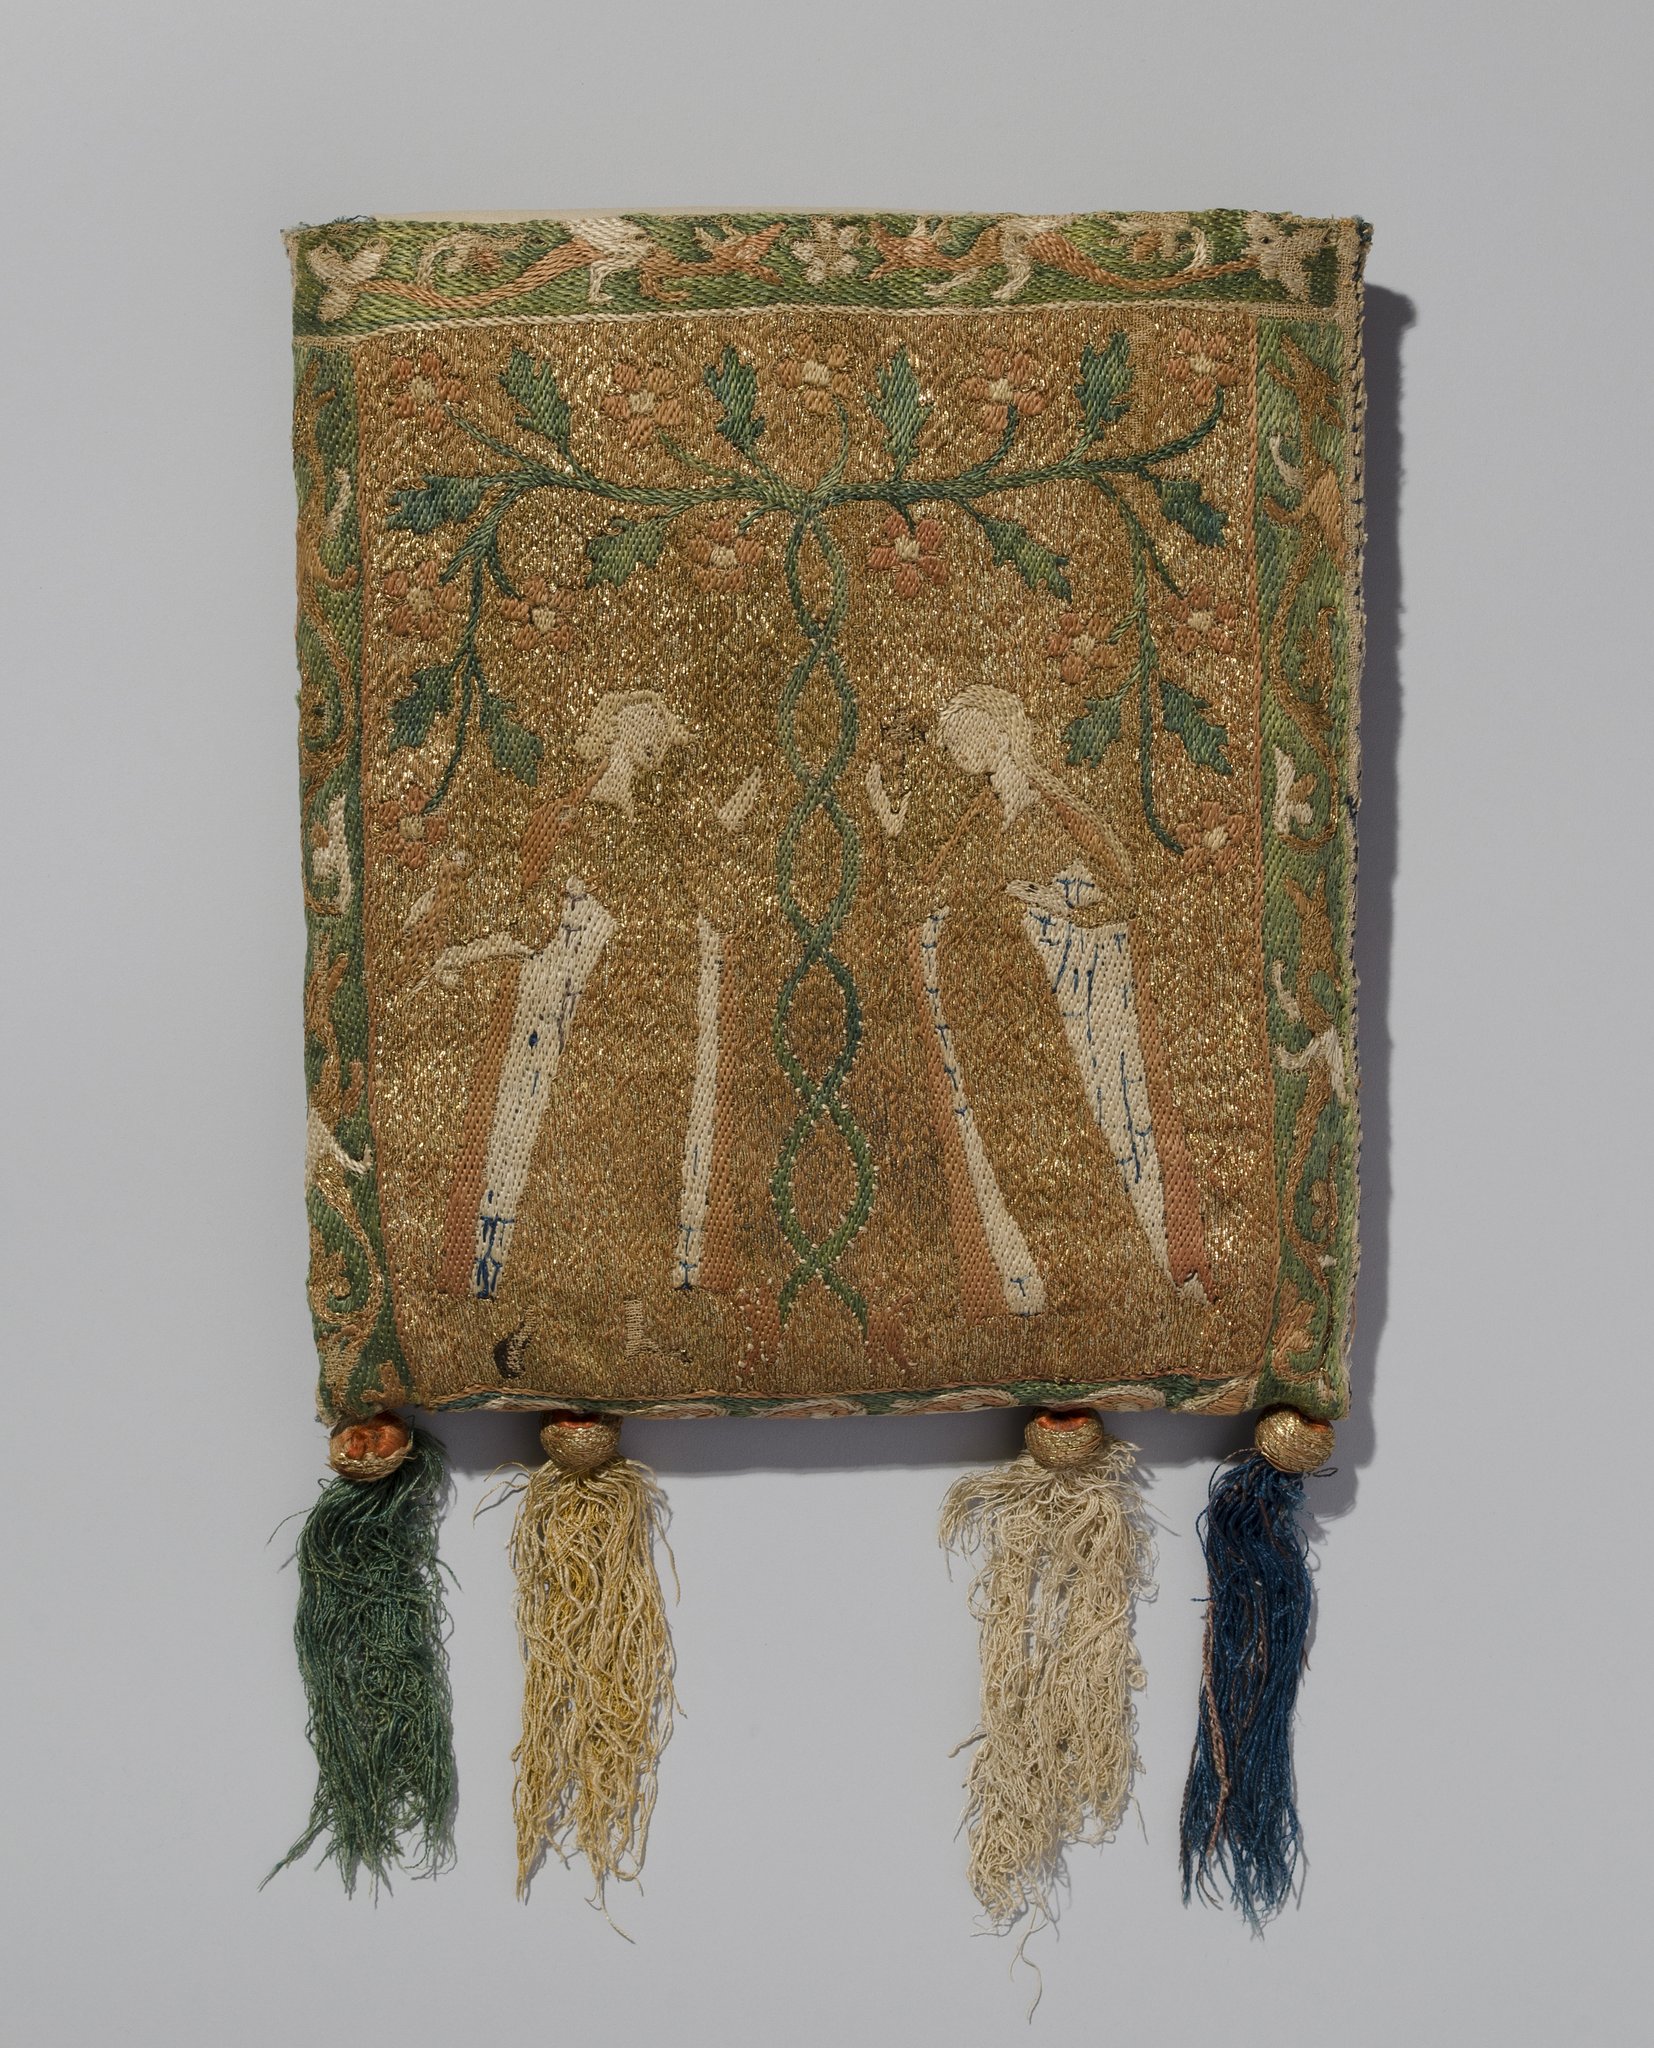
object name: purse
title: Pouch (Forel)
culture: french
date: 1301-1400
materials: canvas, metal thread, silk